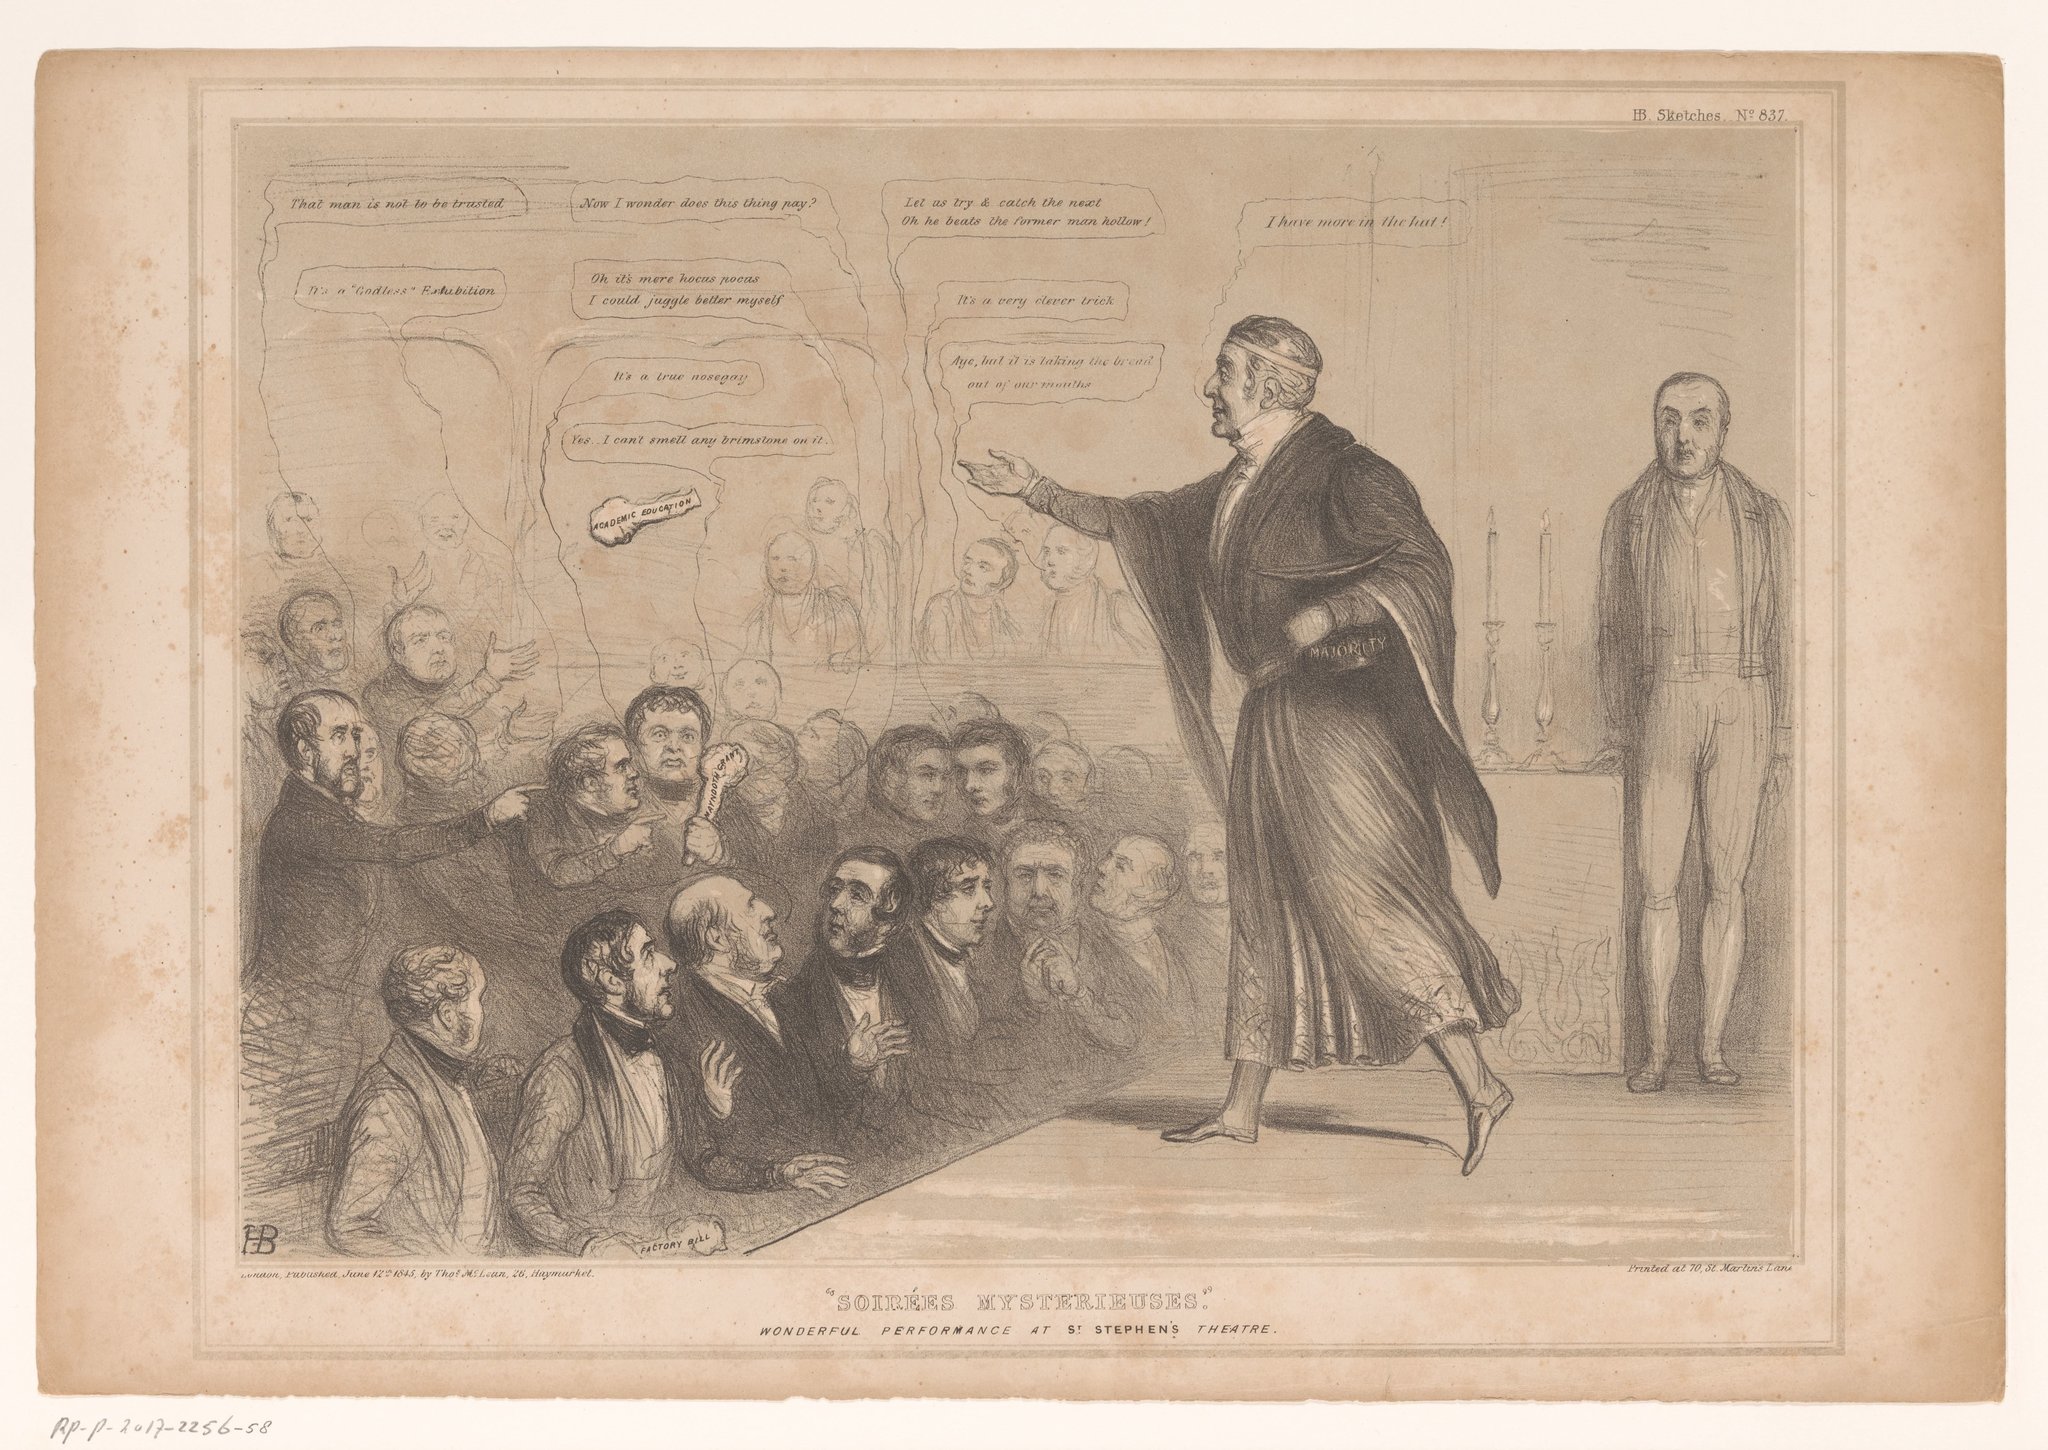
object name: print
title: Spotprent met Sir Robert Peel als goochelaar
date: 1845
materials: paper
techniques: tone lithography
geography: london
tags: london, illusionist, conjurer, juggler, 'legerdemain', political caricatures and satires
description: Spotprent uit 1845 met Sir Robert Peel die als goochelaar twee boeketten het publiek in werpt. Uitgegeven als nr. 837 in de serie HB Sketches.